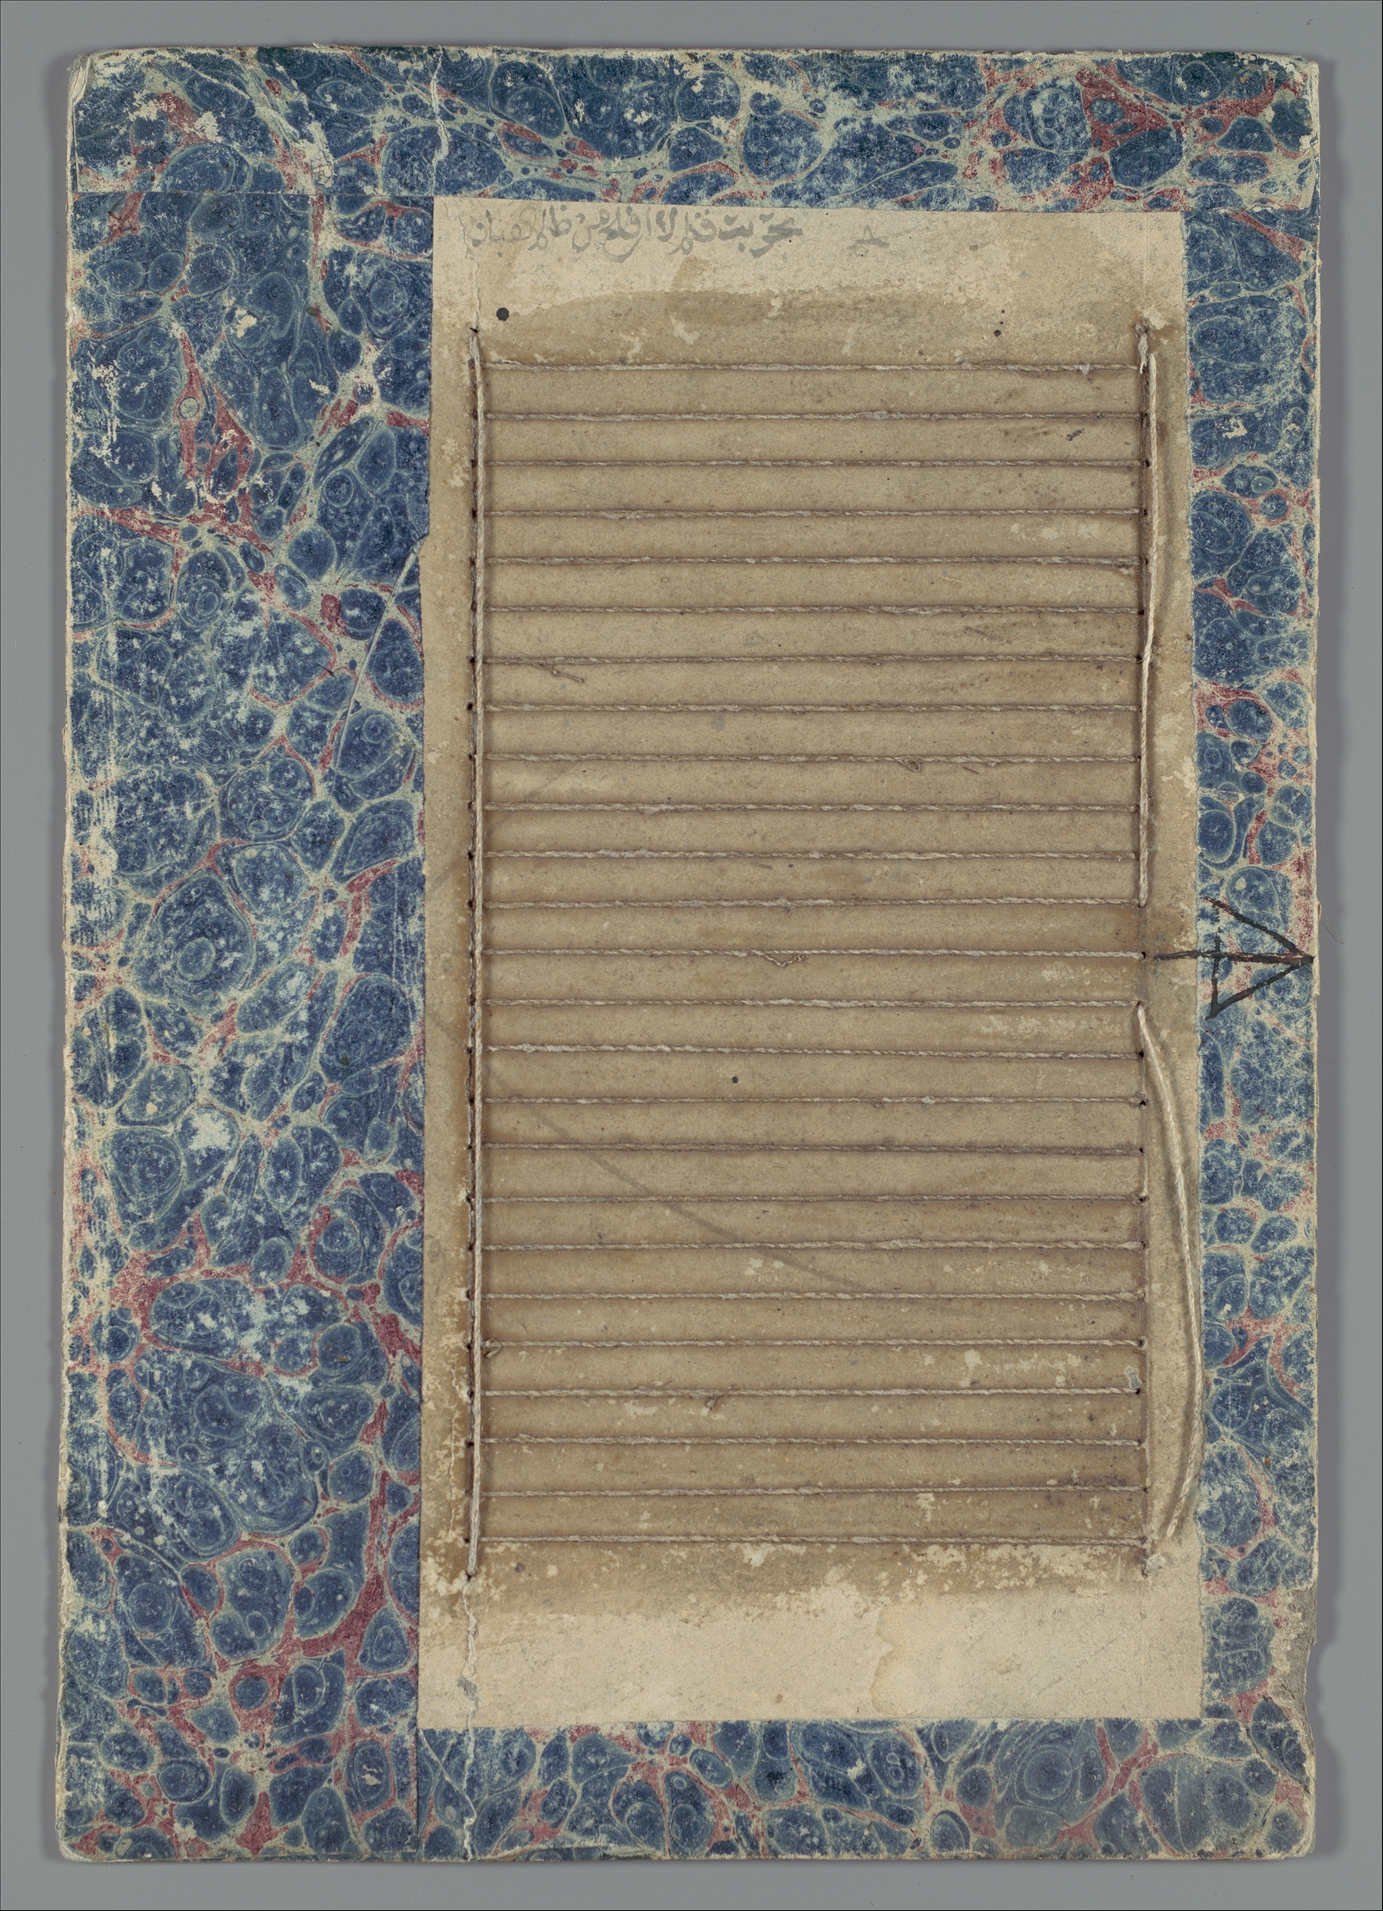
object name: writing tool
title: Board for Ruling Paper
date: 1601-1800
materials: cotton, ink, paper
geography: iran